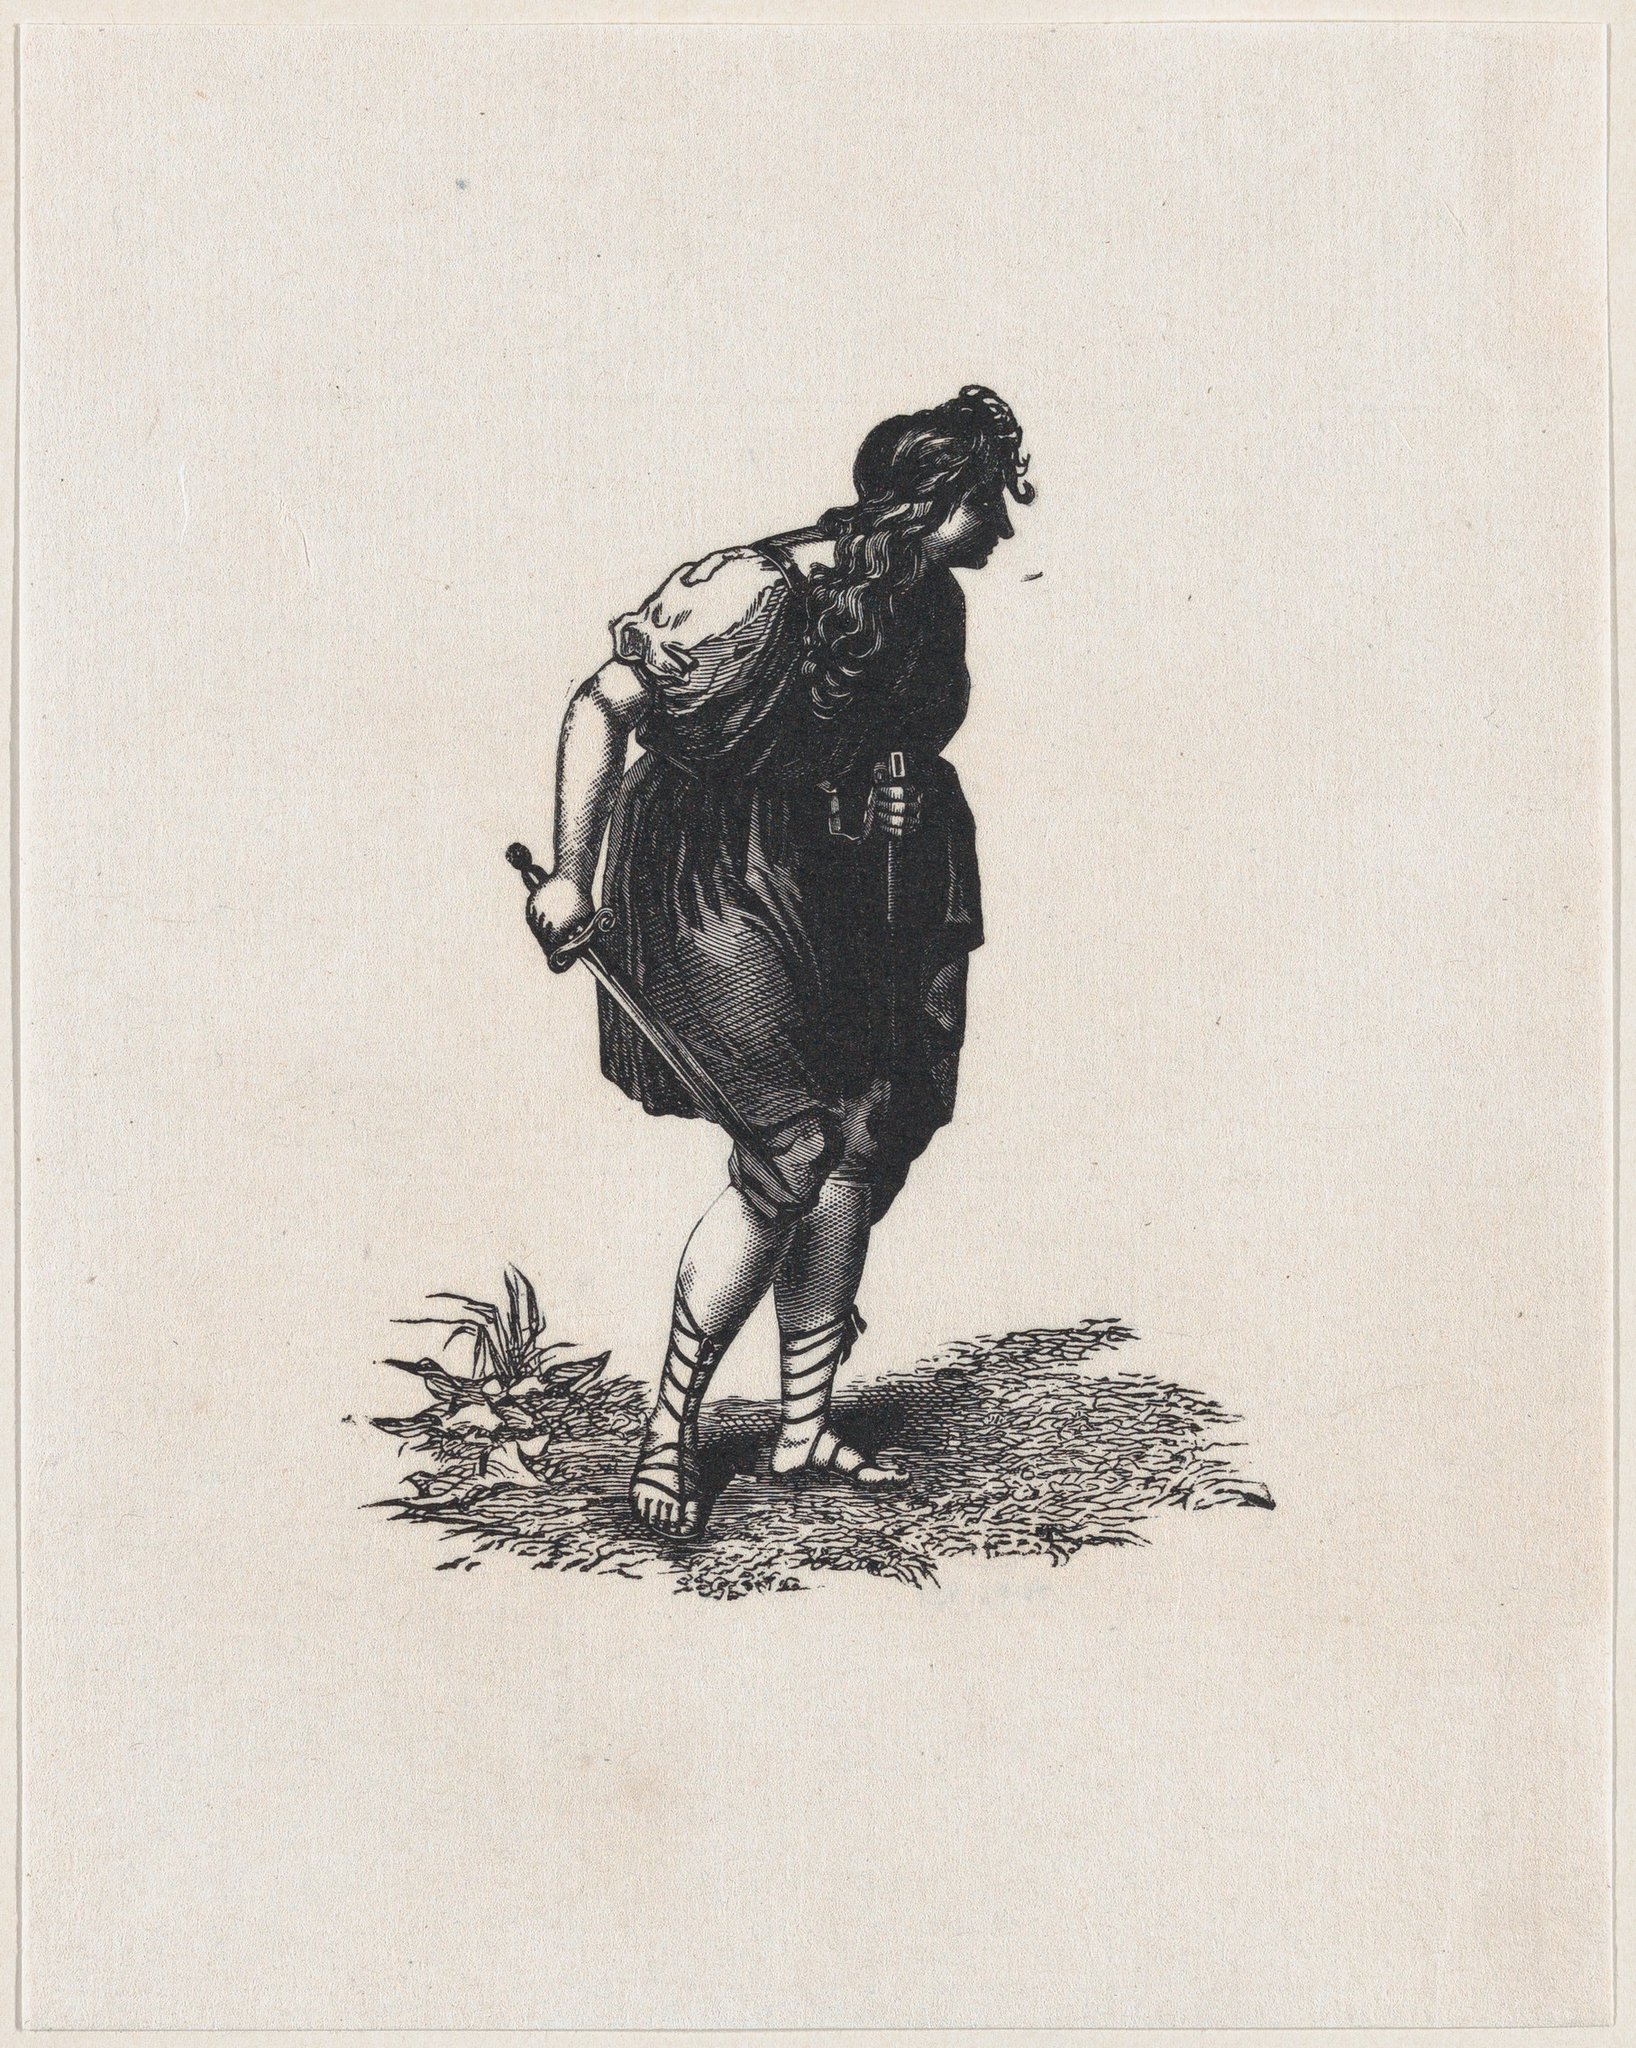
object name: print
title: Imogen hunched over holding a sword, scene from Shakespeare, Cymbeline, Act 3 Scene 6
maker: anonymous, mexican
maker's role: artist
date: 1801-1900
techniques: engraving